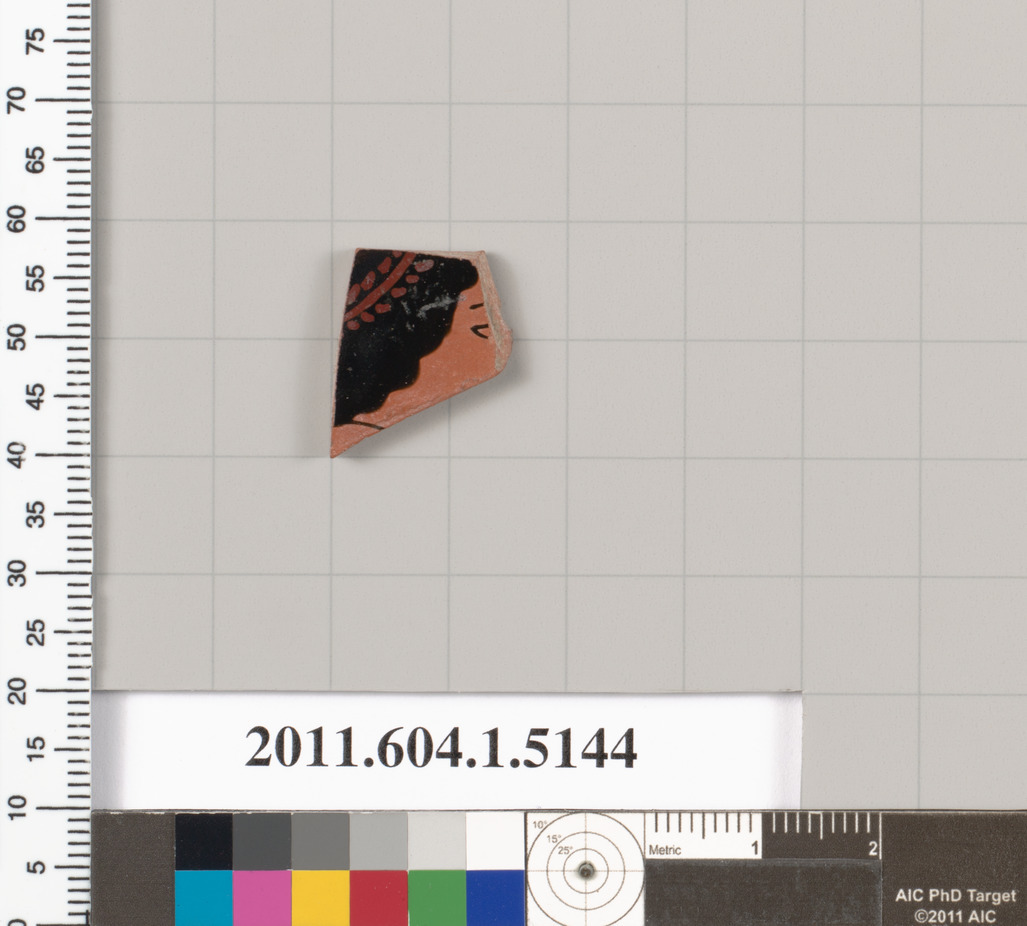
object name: kylix fragment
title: Terracotta fragment of a kylix (drinking cup)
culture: greek, attic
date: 510-490 BCE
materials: terracotta